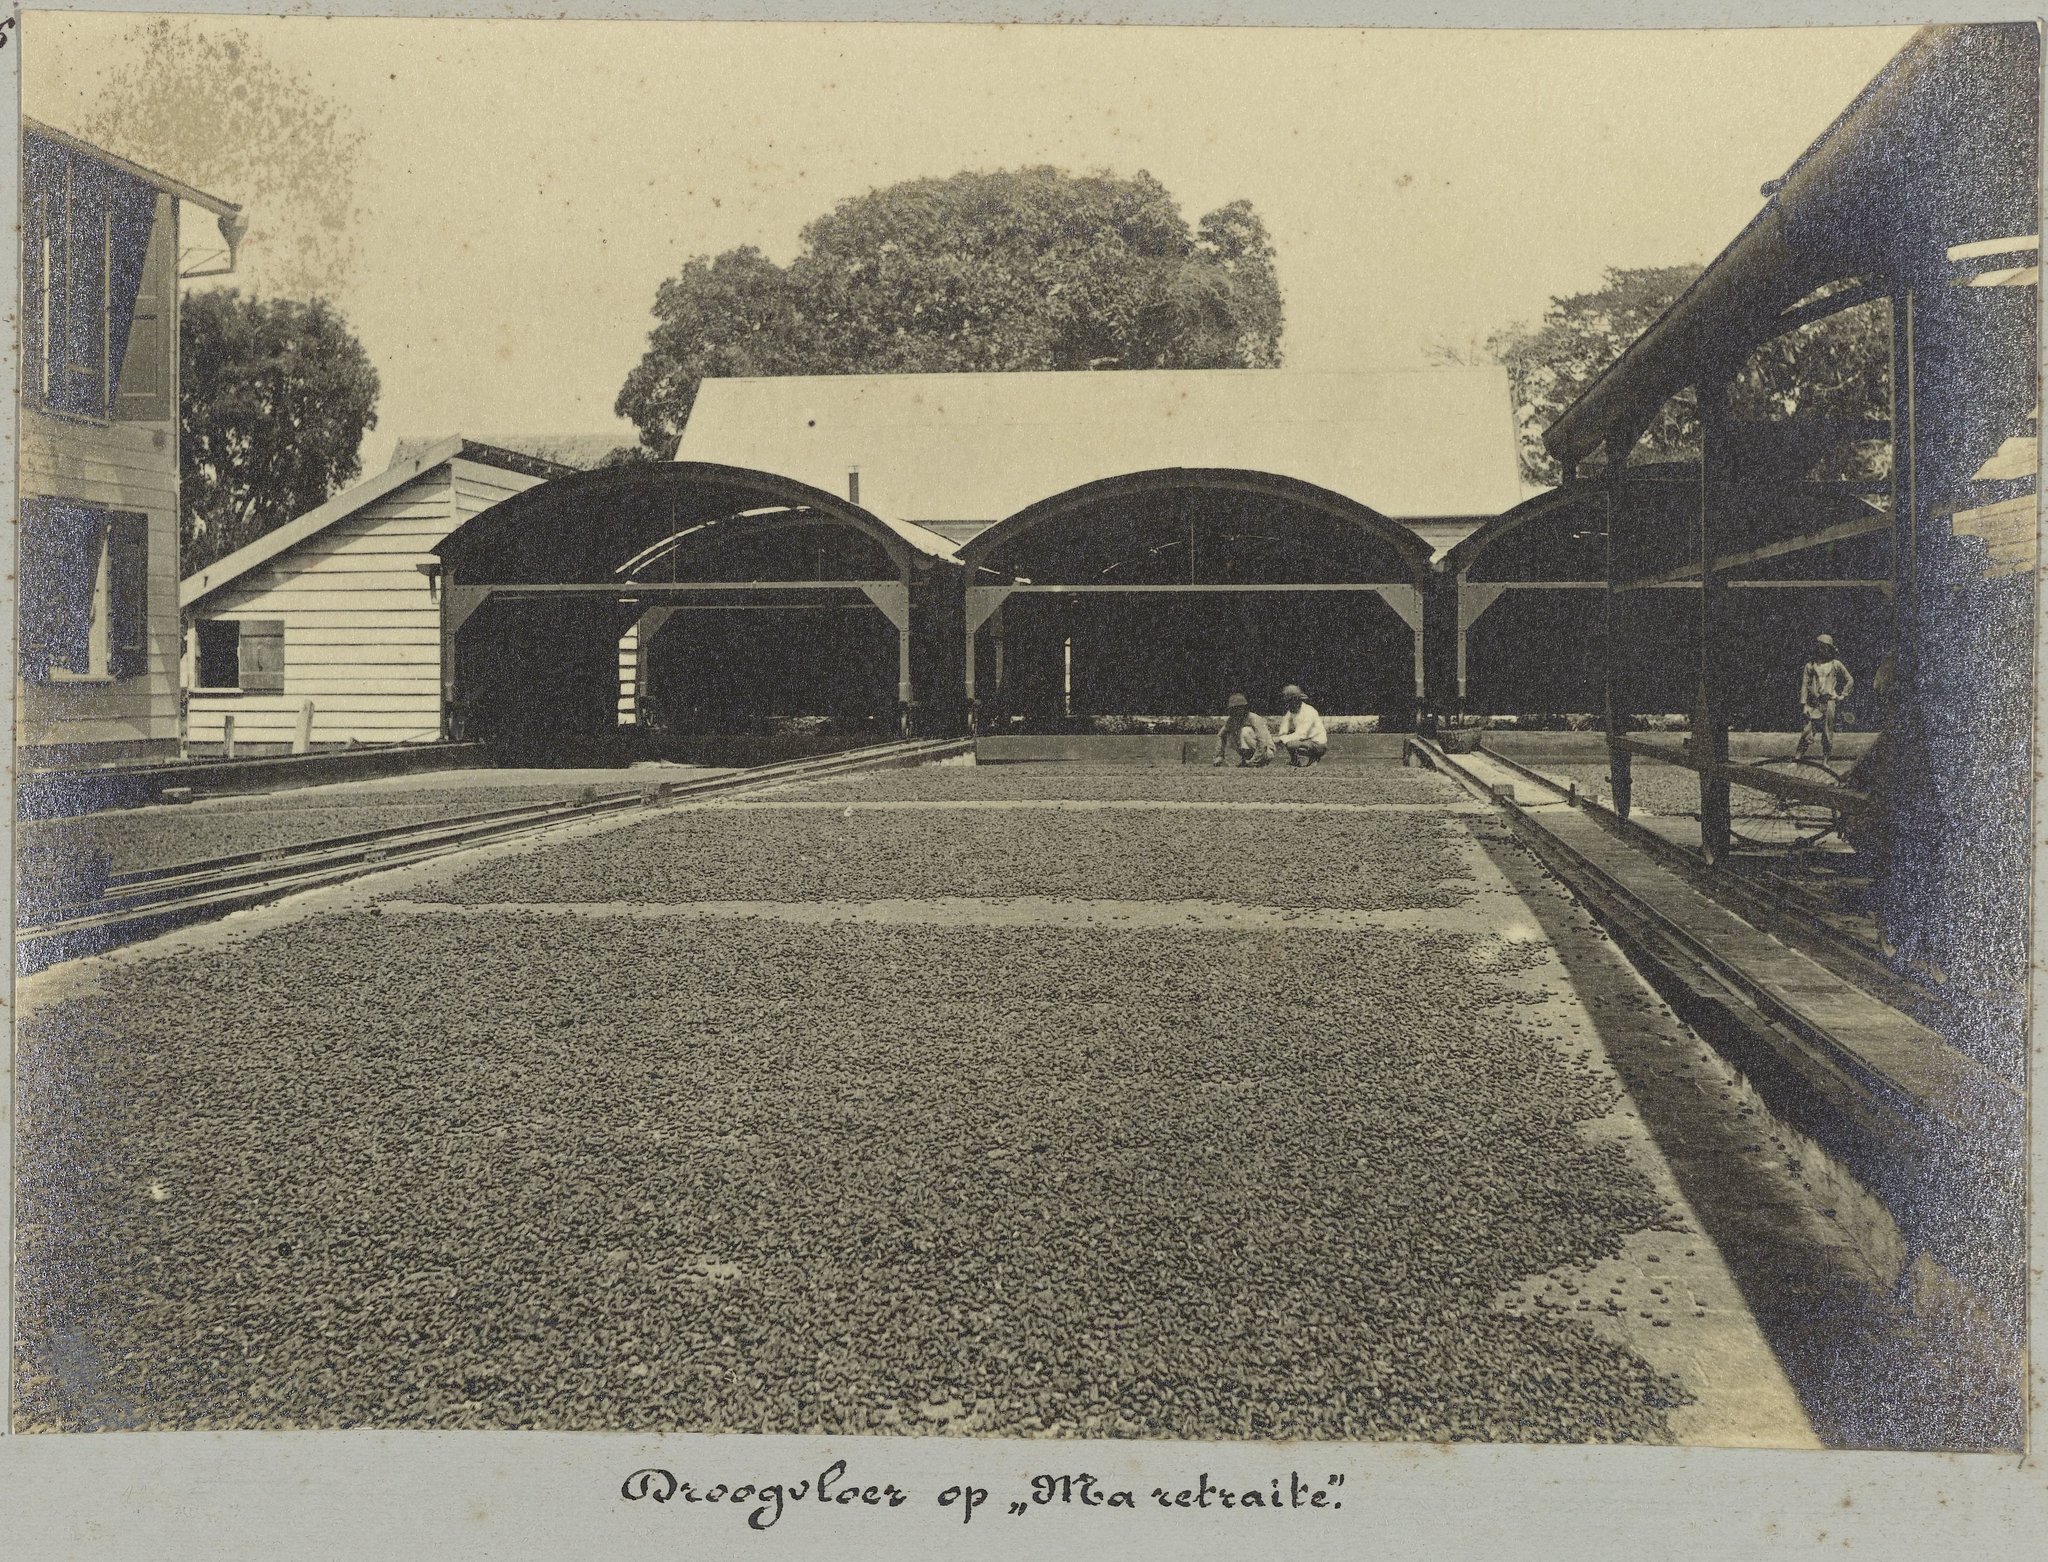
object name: photograph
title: Droogvloer op "Ma retraite"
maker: hendrik doijer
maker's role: engineer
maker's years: 1863-1925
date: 1903-1910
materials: photographic support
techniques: gelatin silver print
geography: suriname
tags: suriname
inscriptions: inscription: ‘B6 / Droogvloer op "Ma retraite".’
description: Cacaobonen drogend in de zon op droogvloeren bij loodsen op het terrein van de plantage Ma Retraite. Onderdeel van het fotoalbum Souvenir de Voyage (deel 1), over het leven van de familie Doijer in en rond de plantage Ma Retraite in Suriname in de jaren 1903-1910.